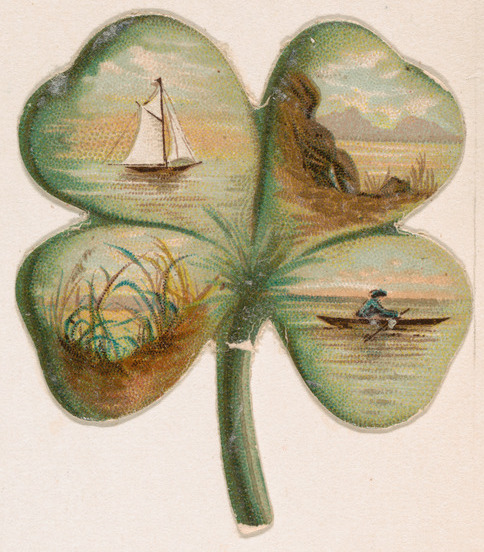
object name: print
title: Four-leaf clover, from the Novelties series (N228, Type 4) issued by Kinney Bros.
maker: kinney brothers tobacco company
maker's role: publisher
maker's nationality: american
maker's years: 1869-2011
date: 1889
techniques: color lithograph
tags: human figures,leaves,boats,ships